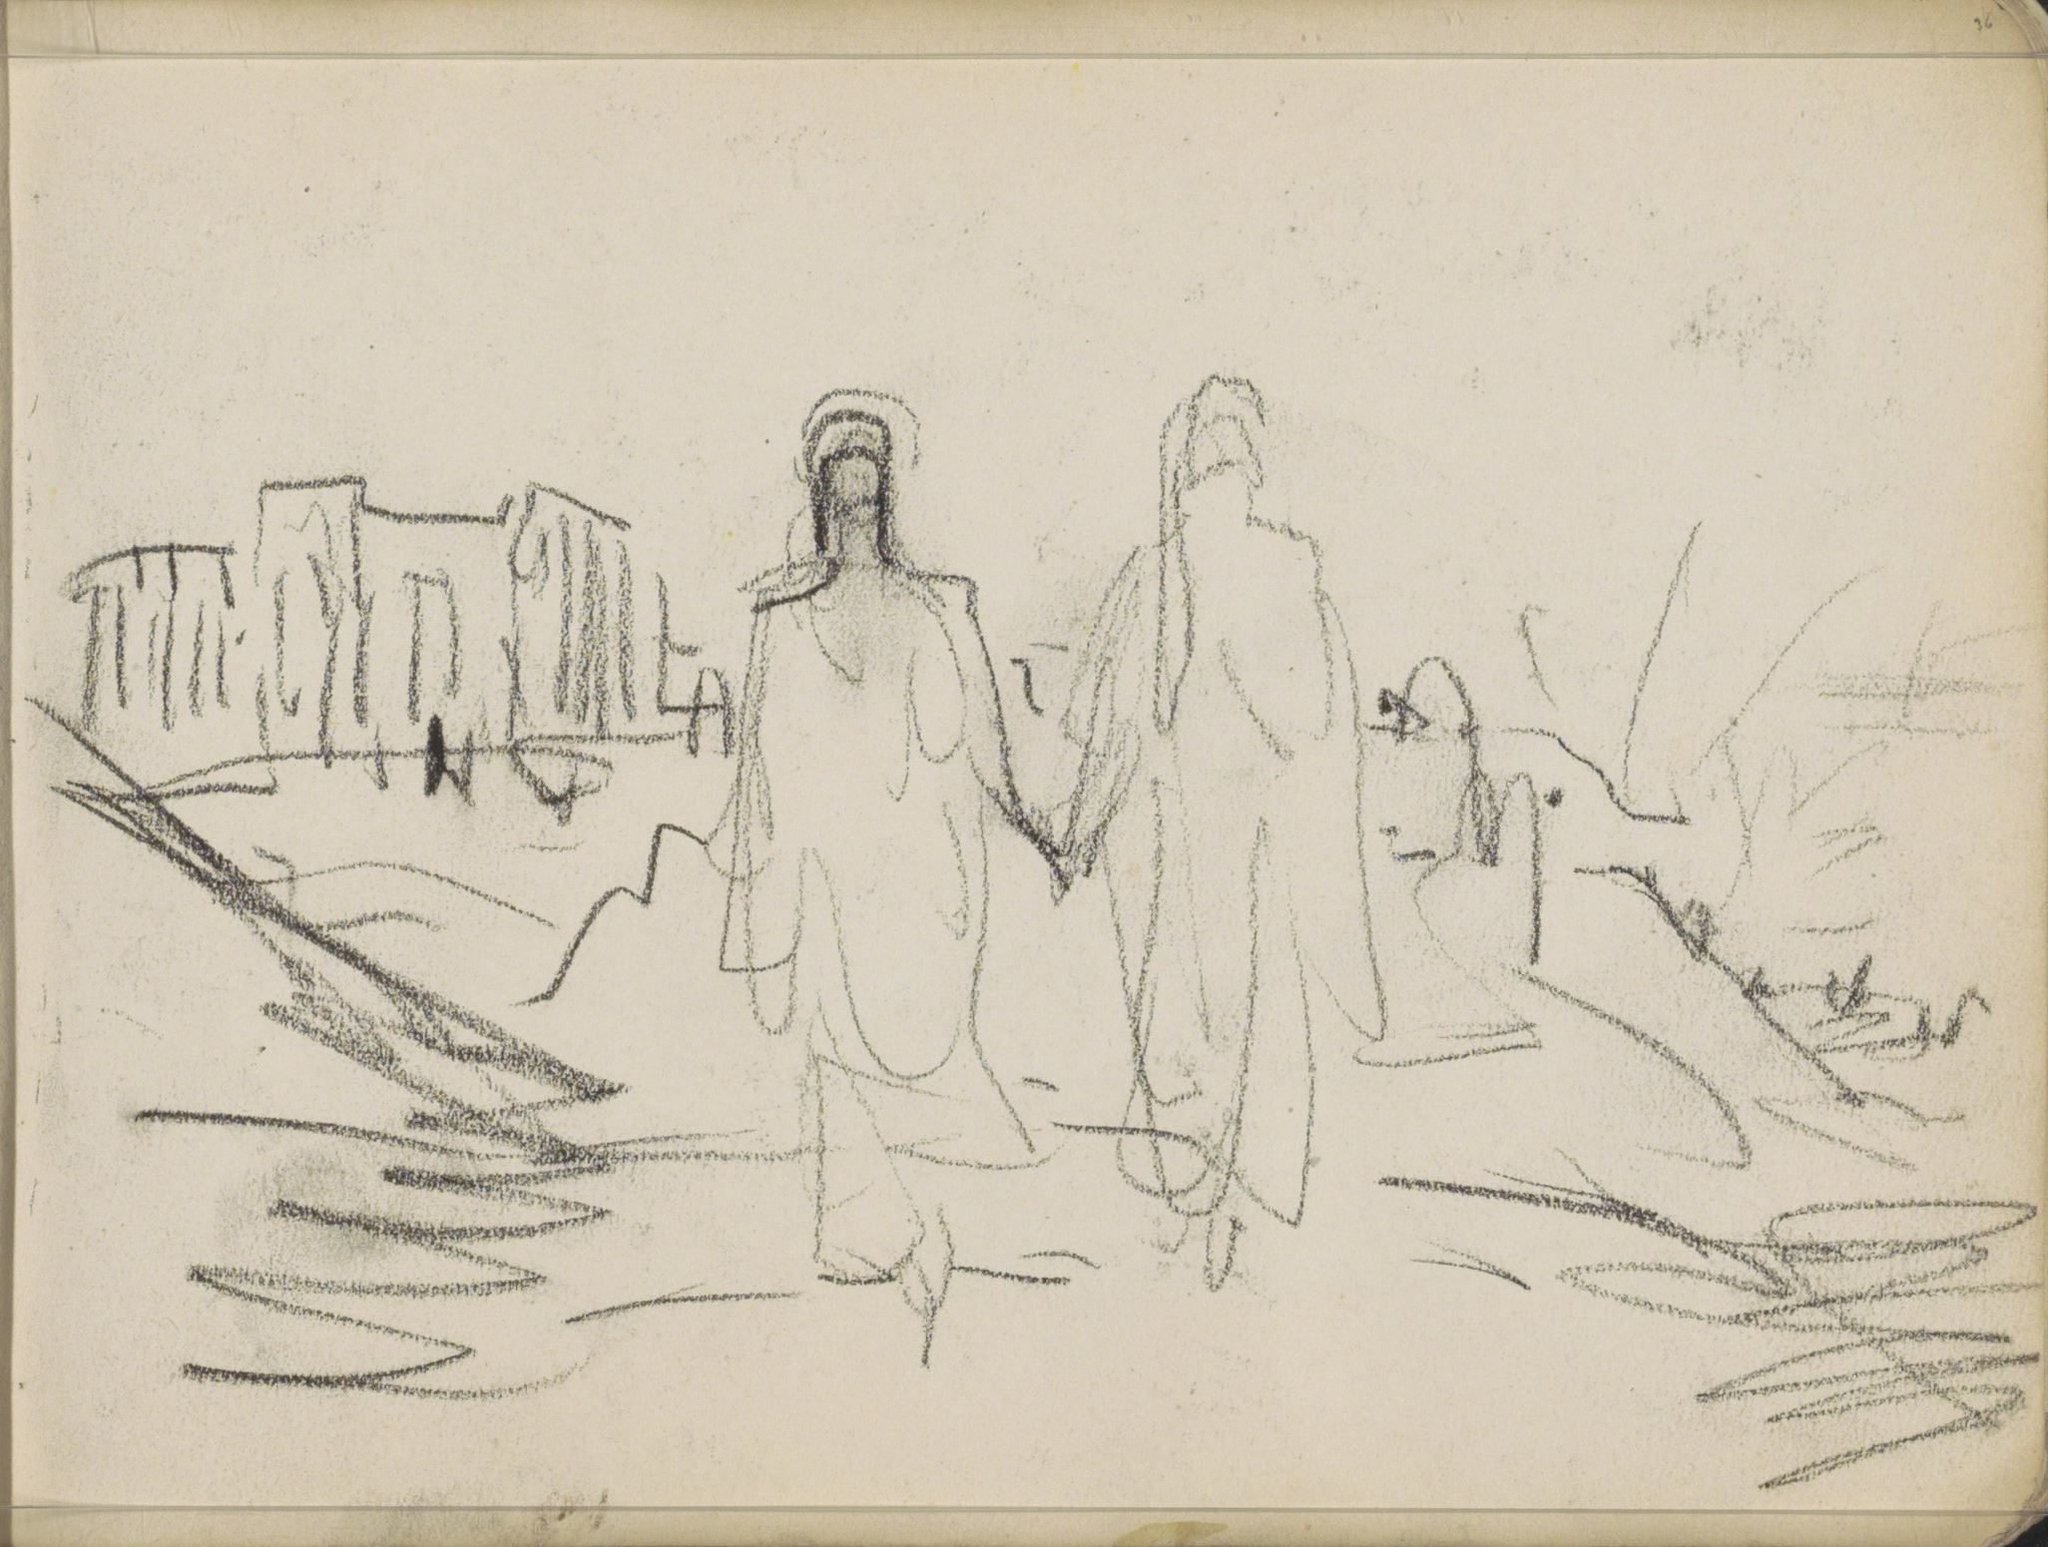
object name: sketchbook leaf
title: Twee figuren bij een tempel, mogelijk de Luxortempel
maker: marius bauer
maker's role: draughtsman, print maker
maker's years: 1867-1932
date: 1919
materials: chalk, paper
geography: luxor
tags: city-view, and landscape with man-made constructions, temple, shrine ~ egyptian religion, africans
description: Pagina 36 uit een schetsboek met 28 bladen.